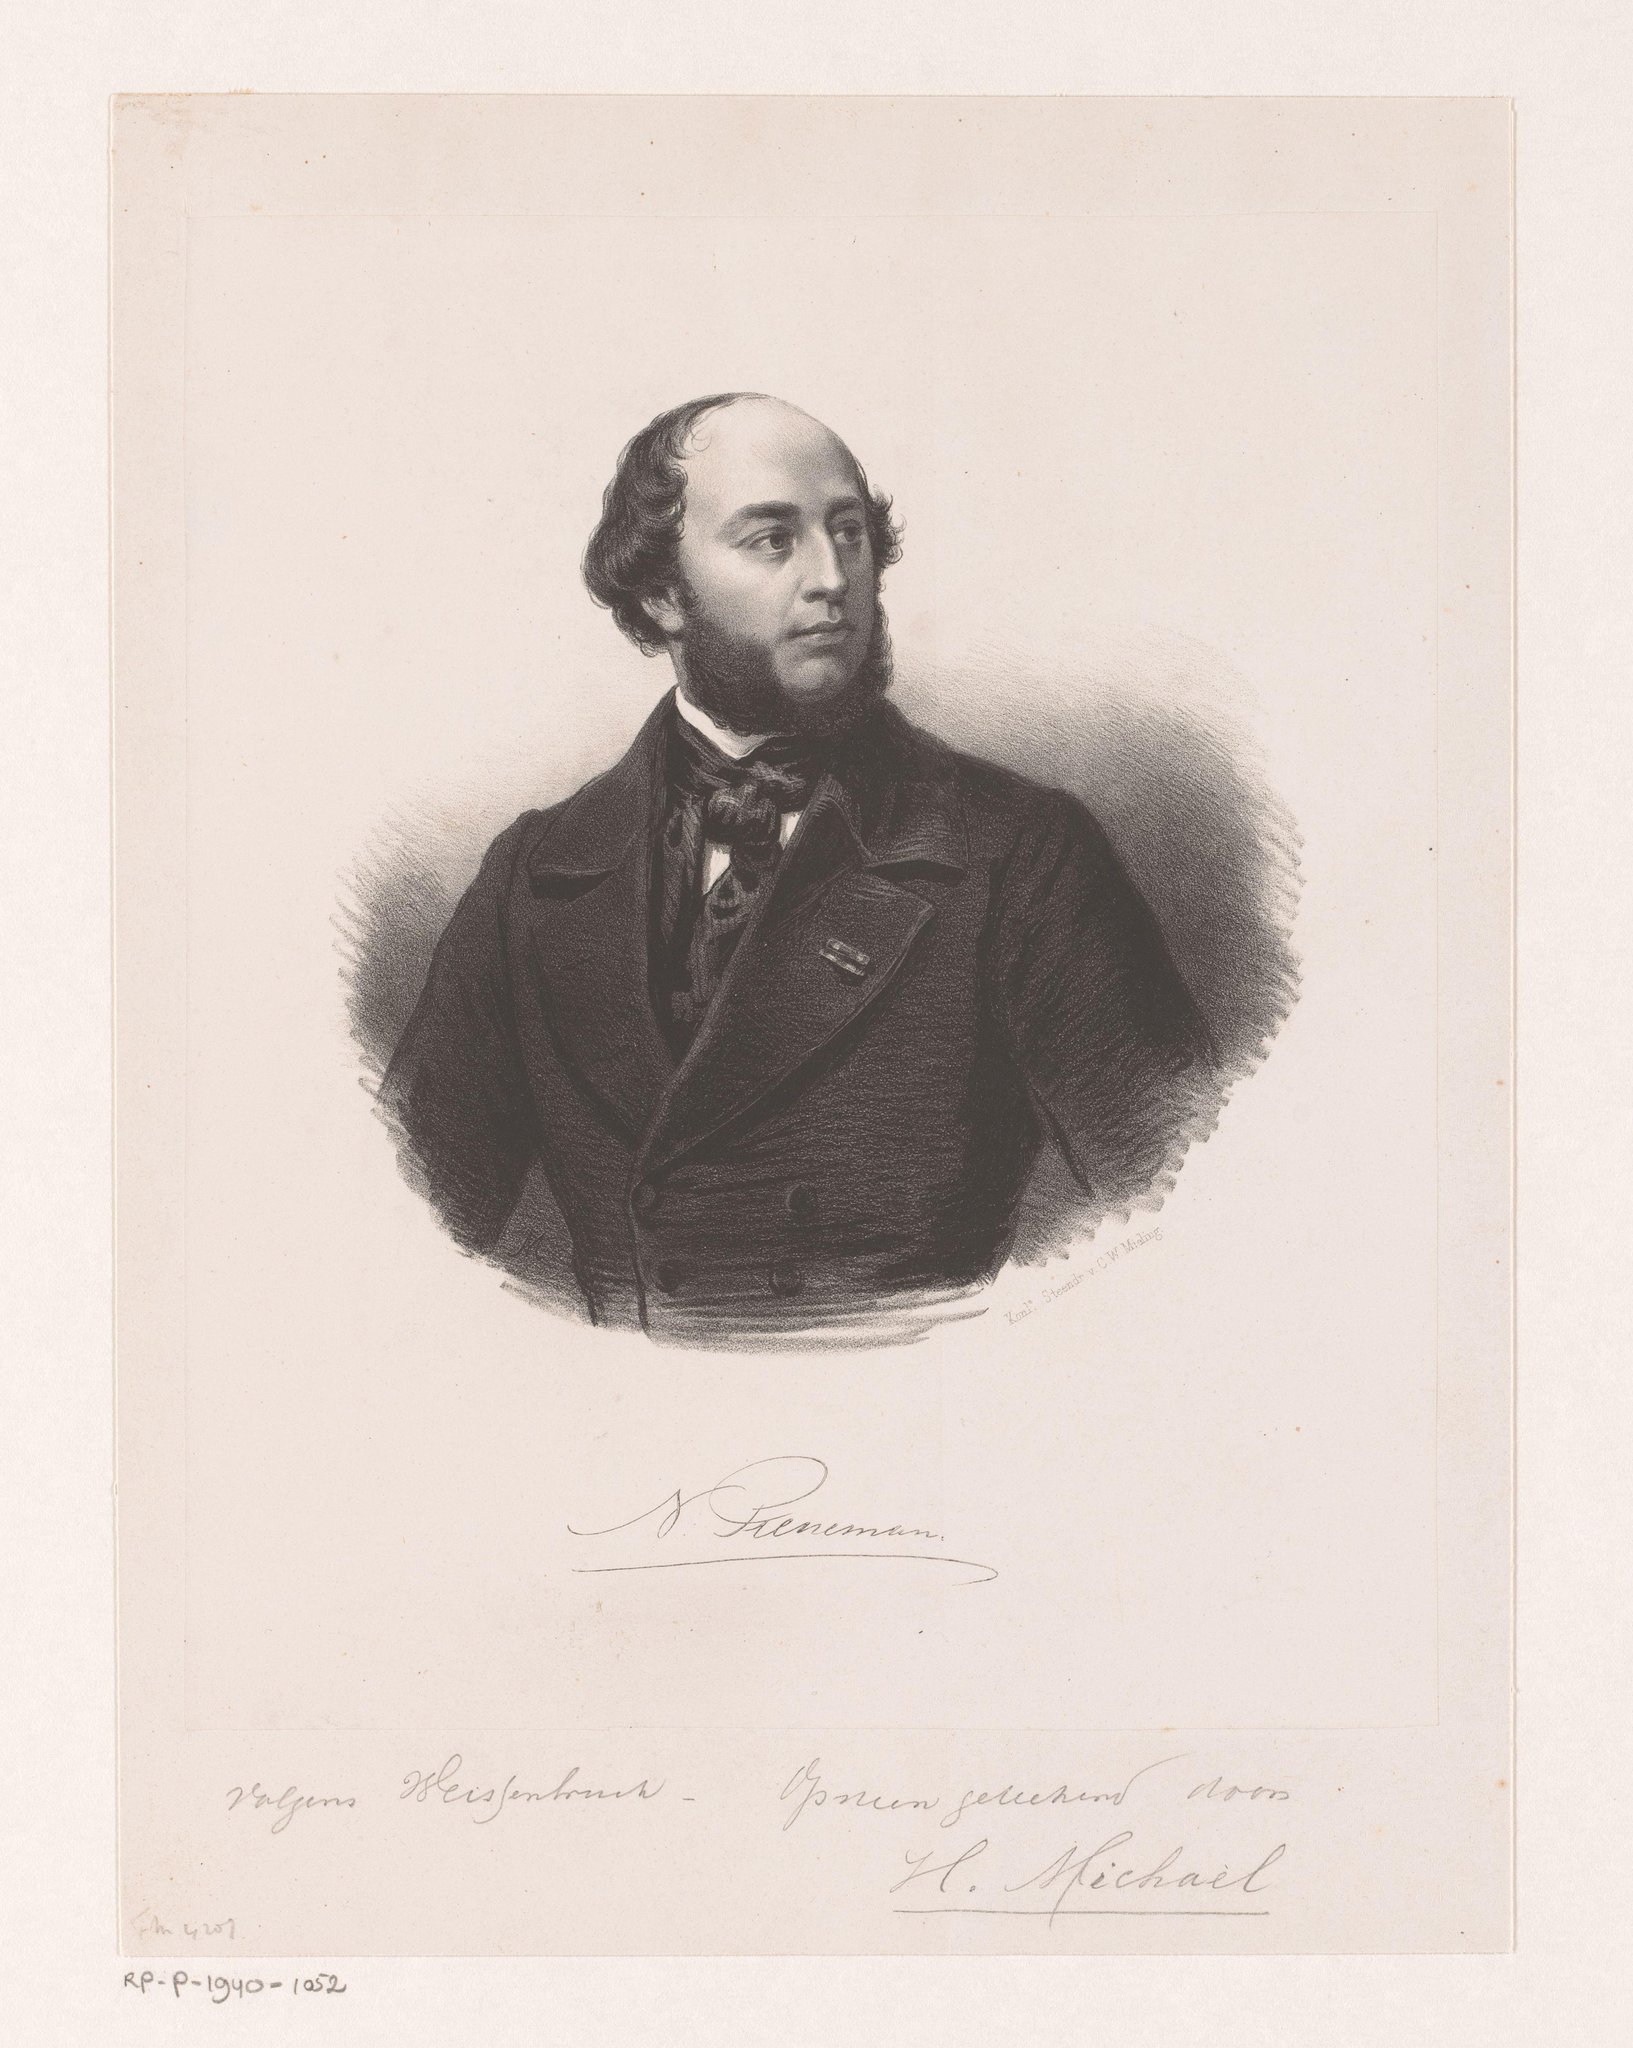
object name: print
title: Portret van Nicolaas Pieneman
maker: hendrikus michael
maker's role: print maker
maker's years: 1814-1849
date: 1847-1853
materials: paper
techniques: lithograph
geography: the hague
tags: amsterdam, painter, draughtsman, nicolaas pieneman, portrait, self-portrait of painter, historical persons (+ (full) bust portrait)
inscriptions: inscription: ‘Volgens Weissenbruch - Op steen getekend door / H. Michael’, collector's mark: Lugt 2228, collector's mark: Lugt 2760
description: Onder het portret de signatuur van de geportretteerde.